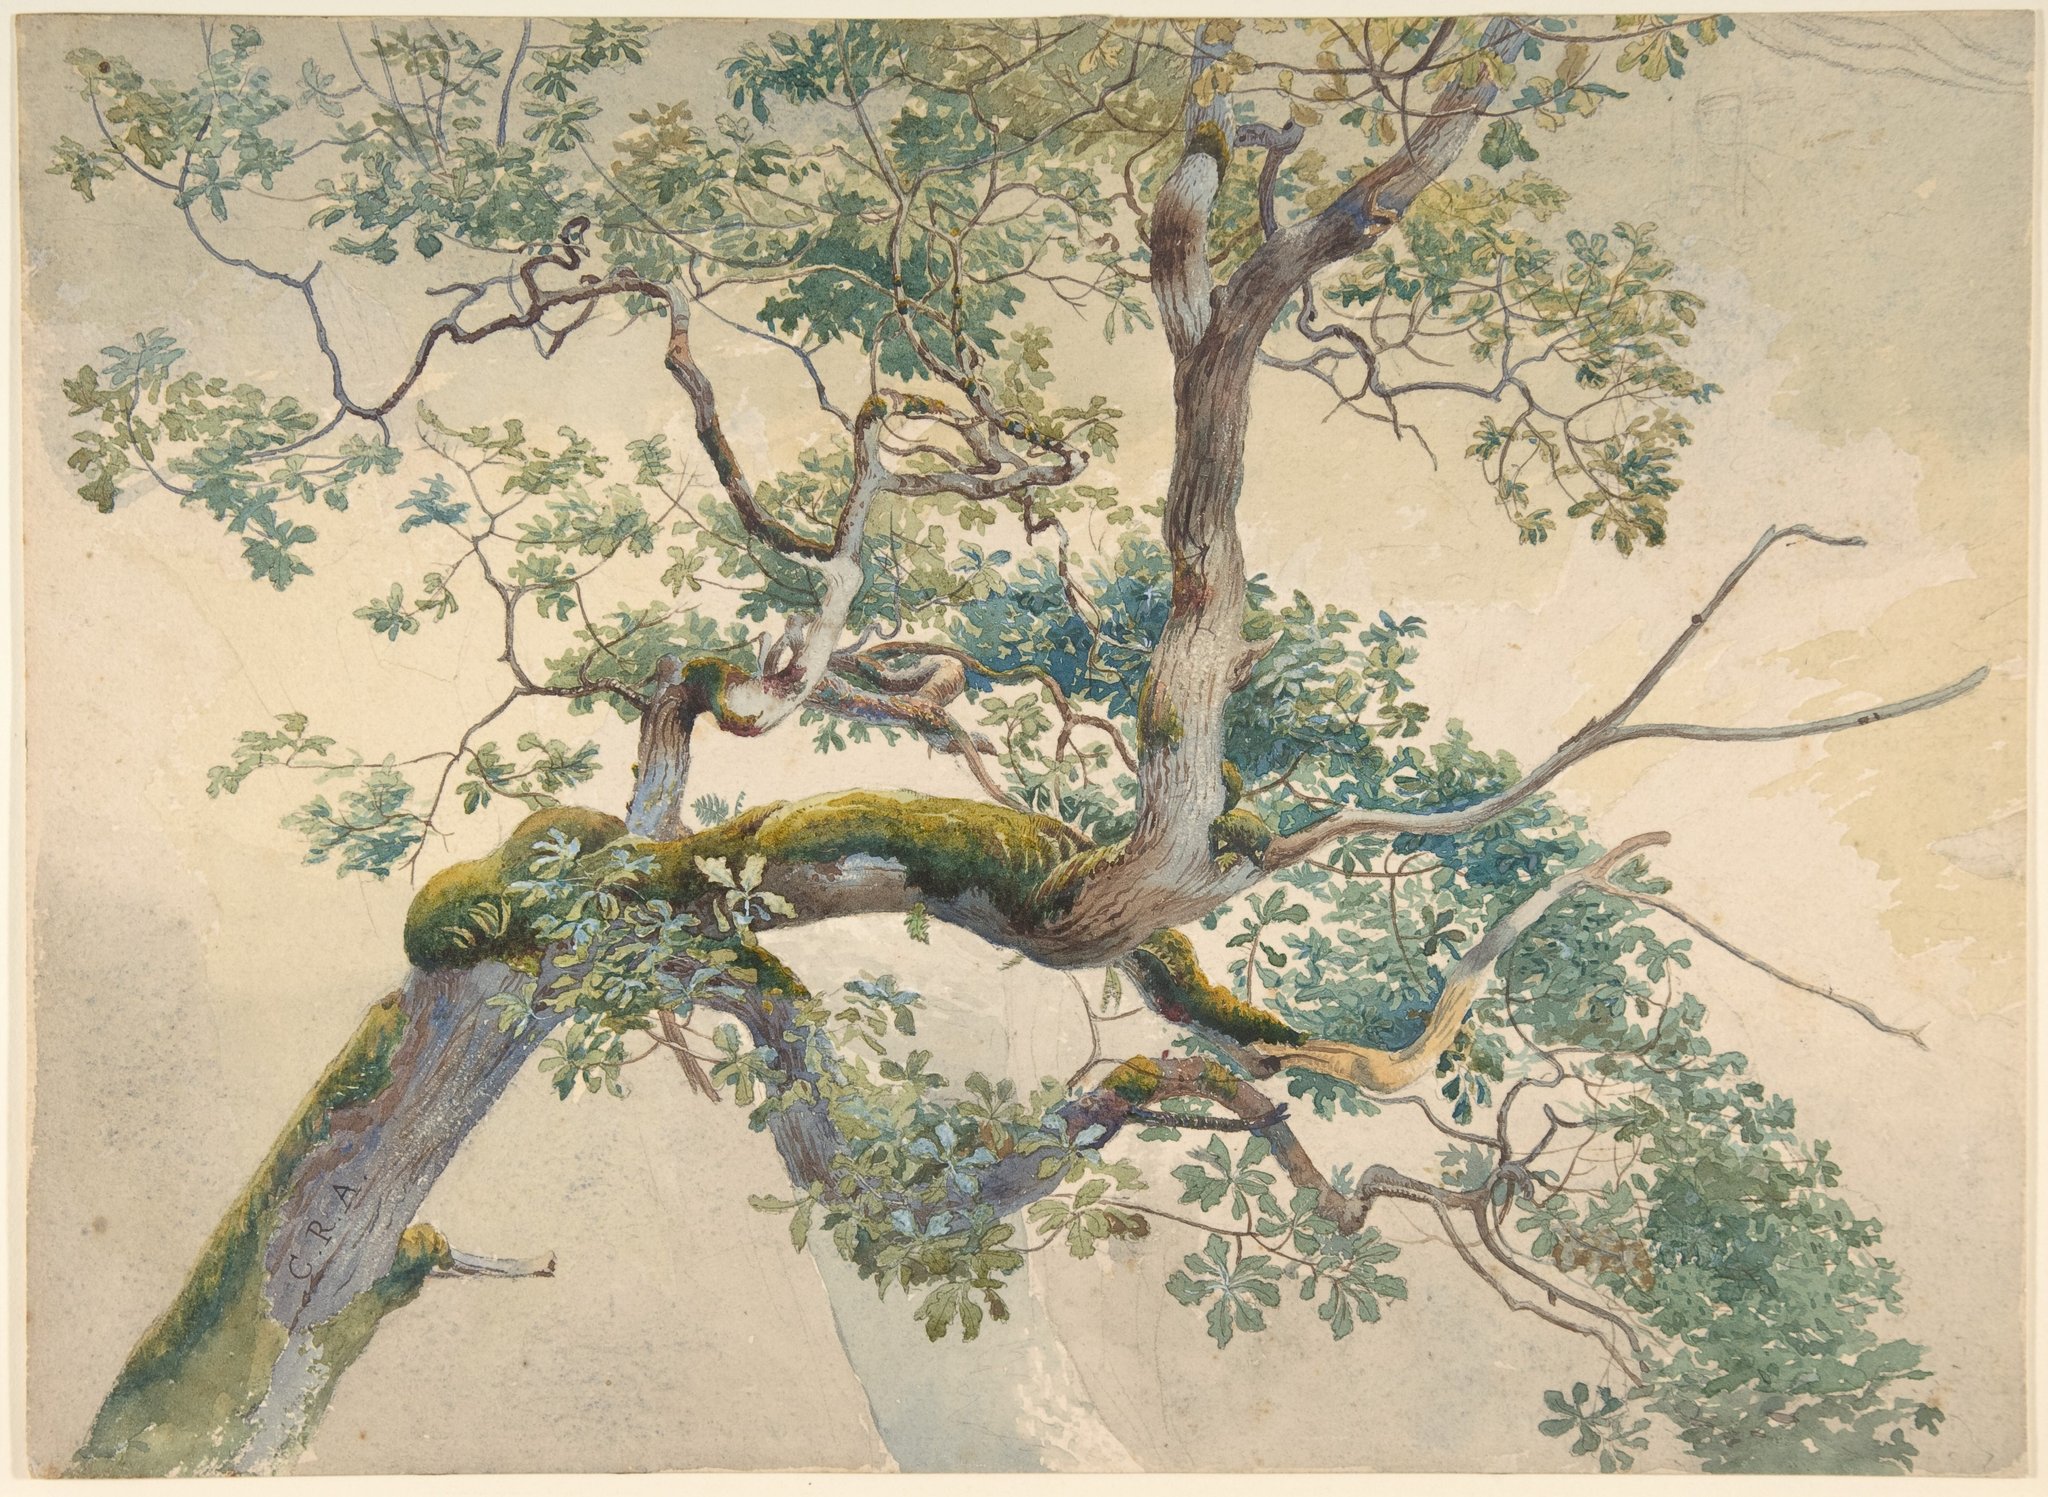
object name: drawing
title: Tree Branches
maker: charles reginald aston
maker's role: artist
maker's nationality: british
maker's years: 1832-1908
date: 1860-1900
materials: graphite, watercolor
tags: trees